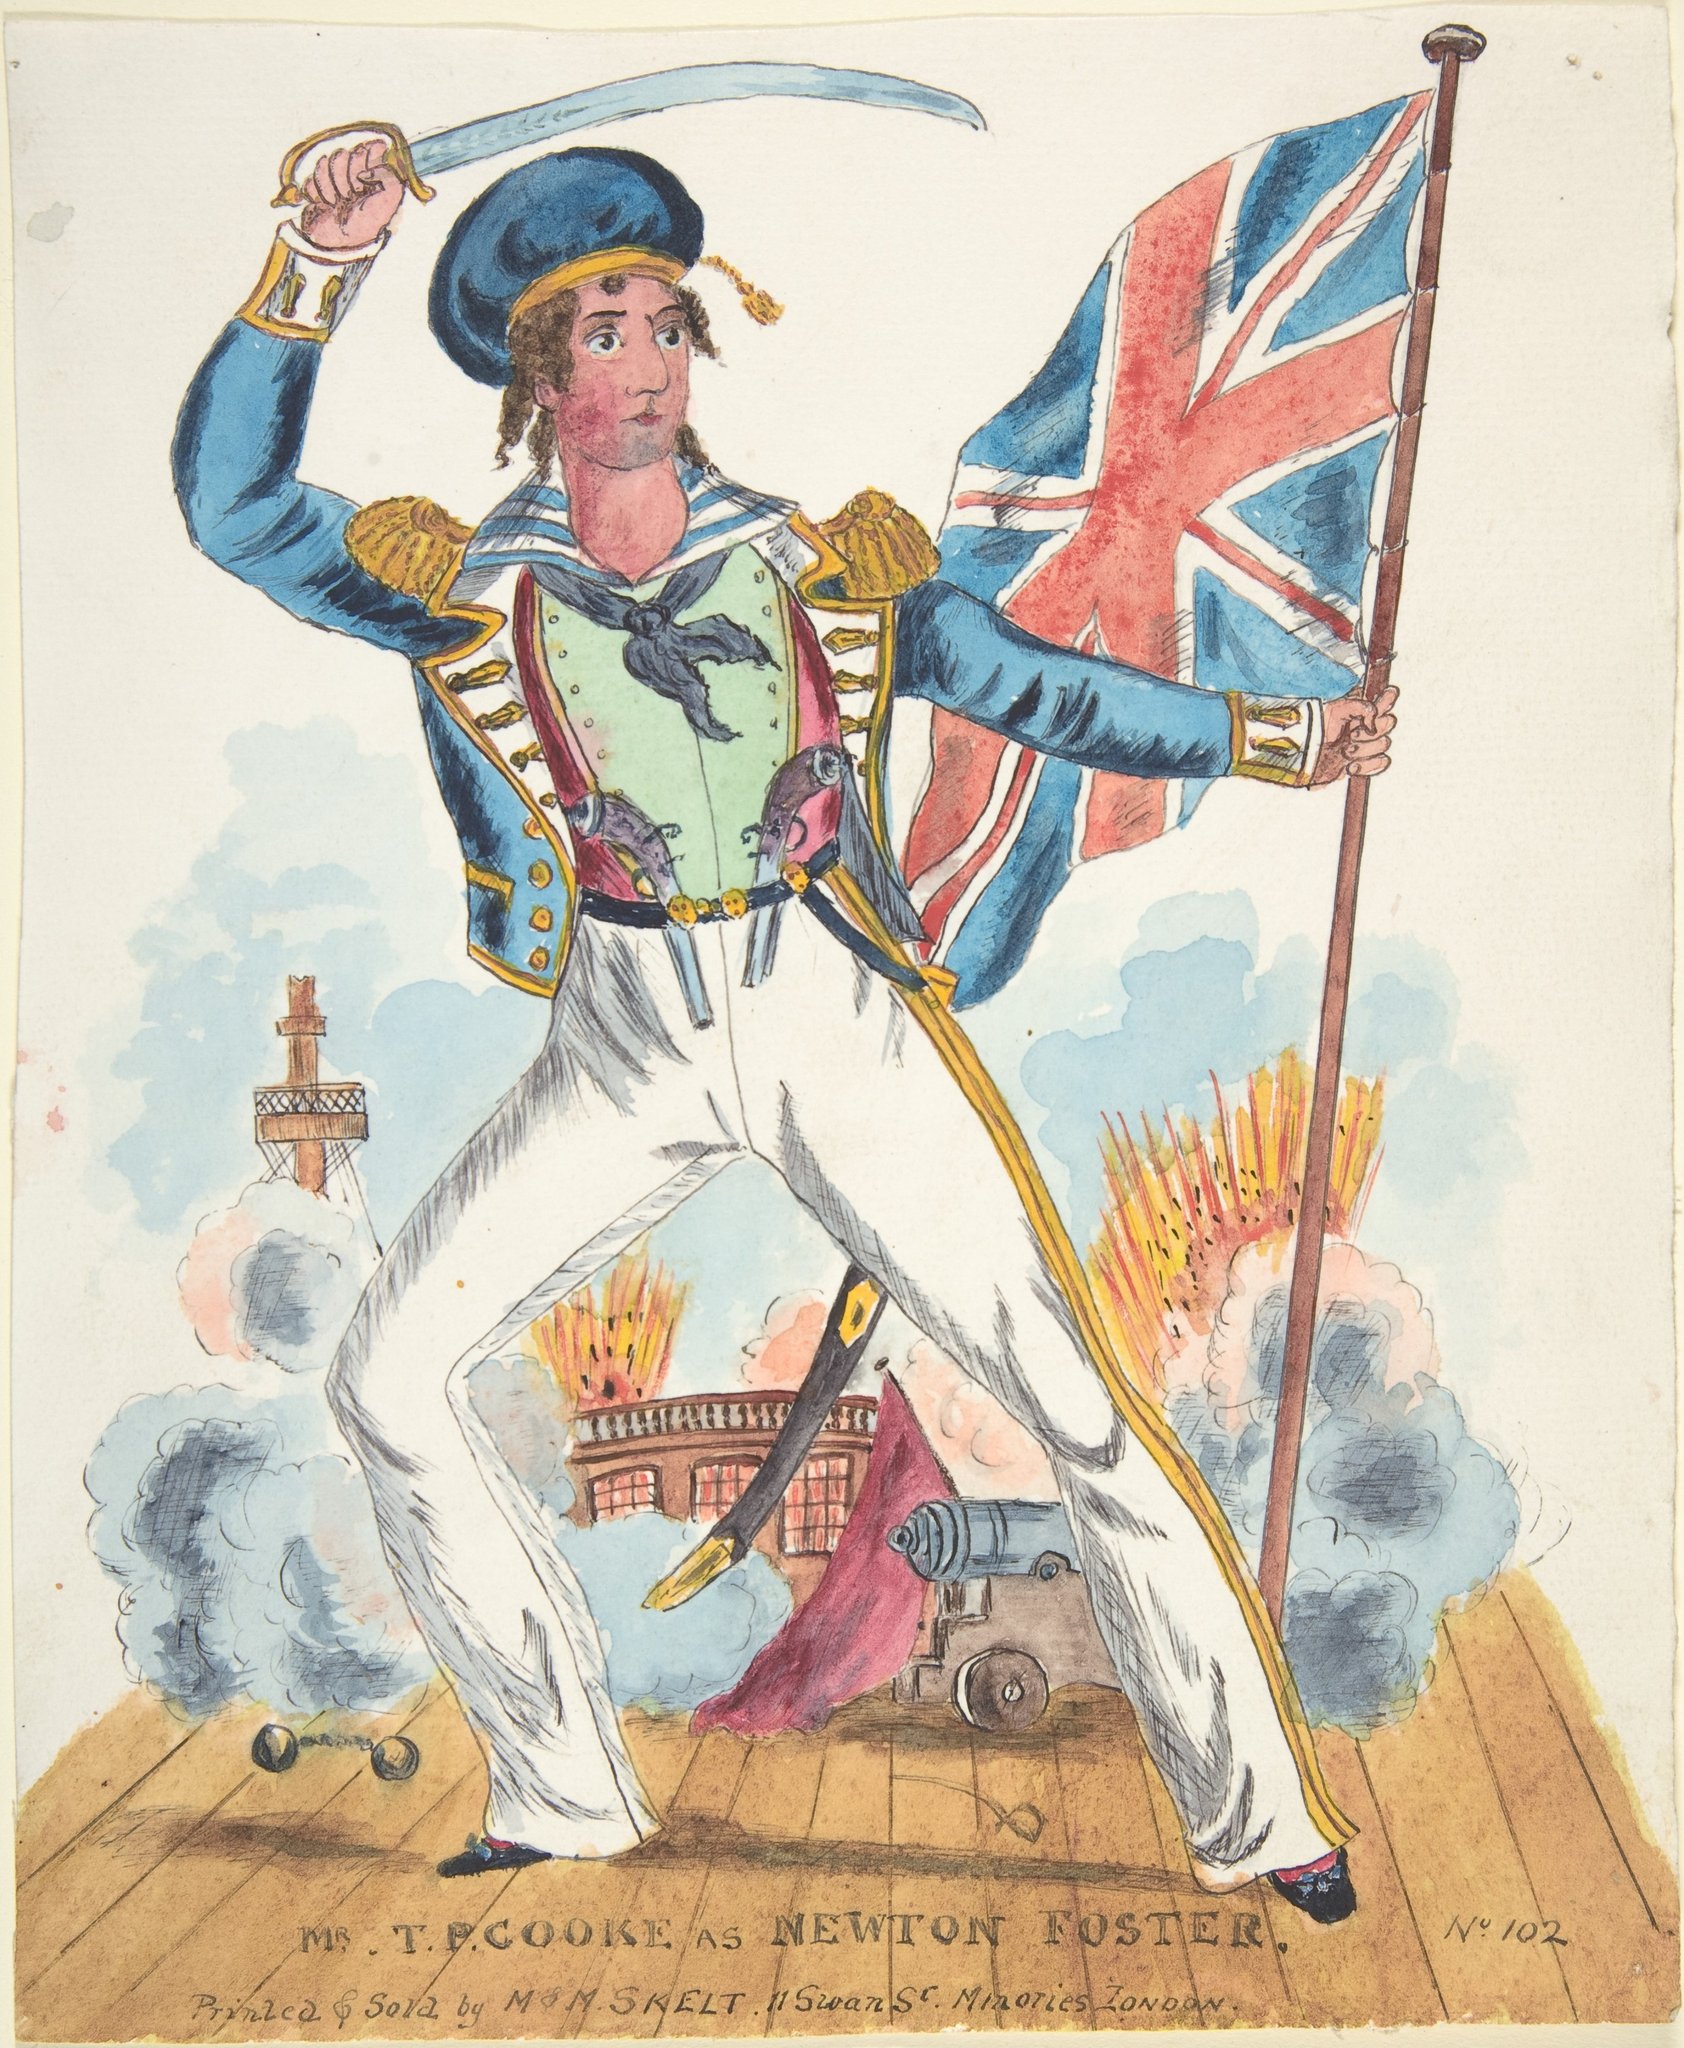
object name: drawing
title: Mr. T. P. Cooke as Newton Foster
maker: anonymous, british, 19th century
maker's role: artist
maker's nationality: british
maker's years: 1800-1900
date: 1801-1900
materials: graphite, ink, watercolor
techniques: pen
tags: soldiers,men,flags